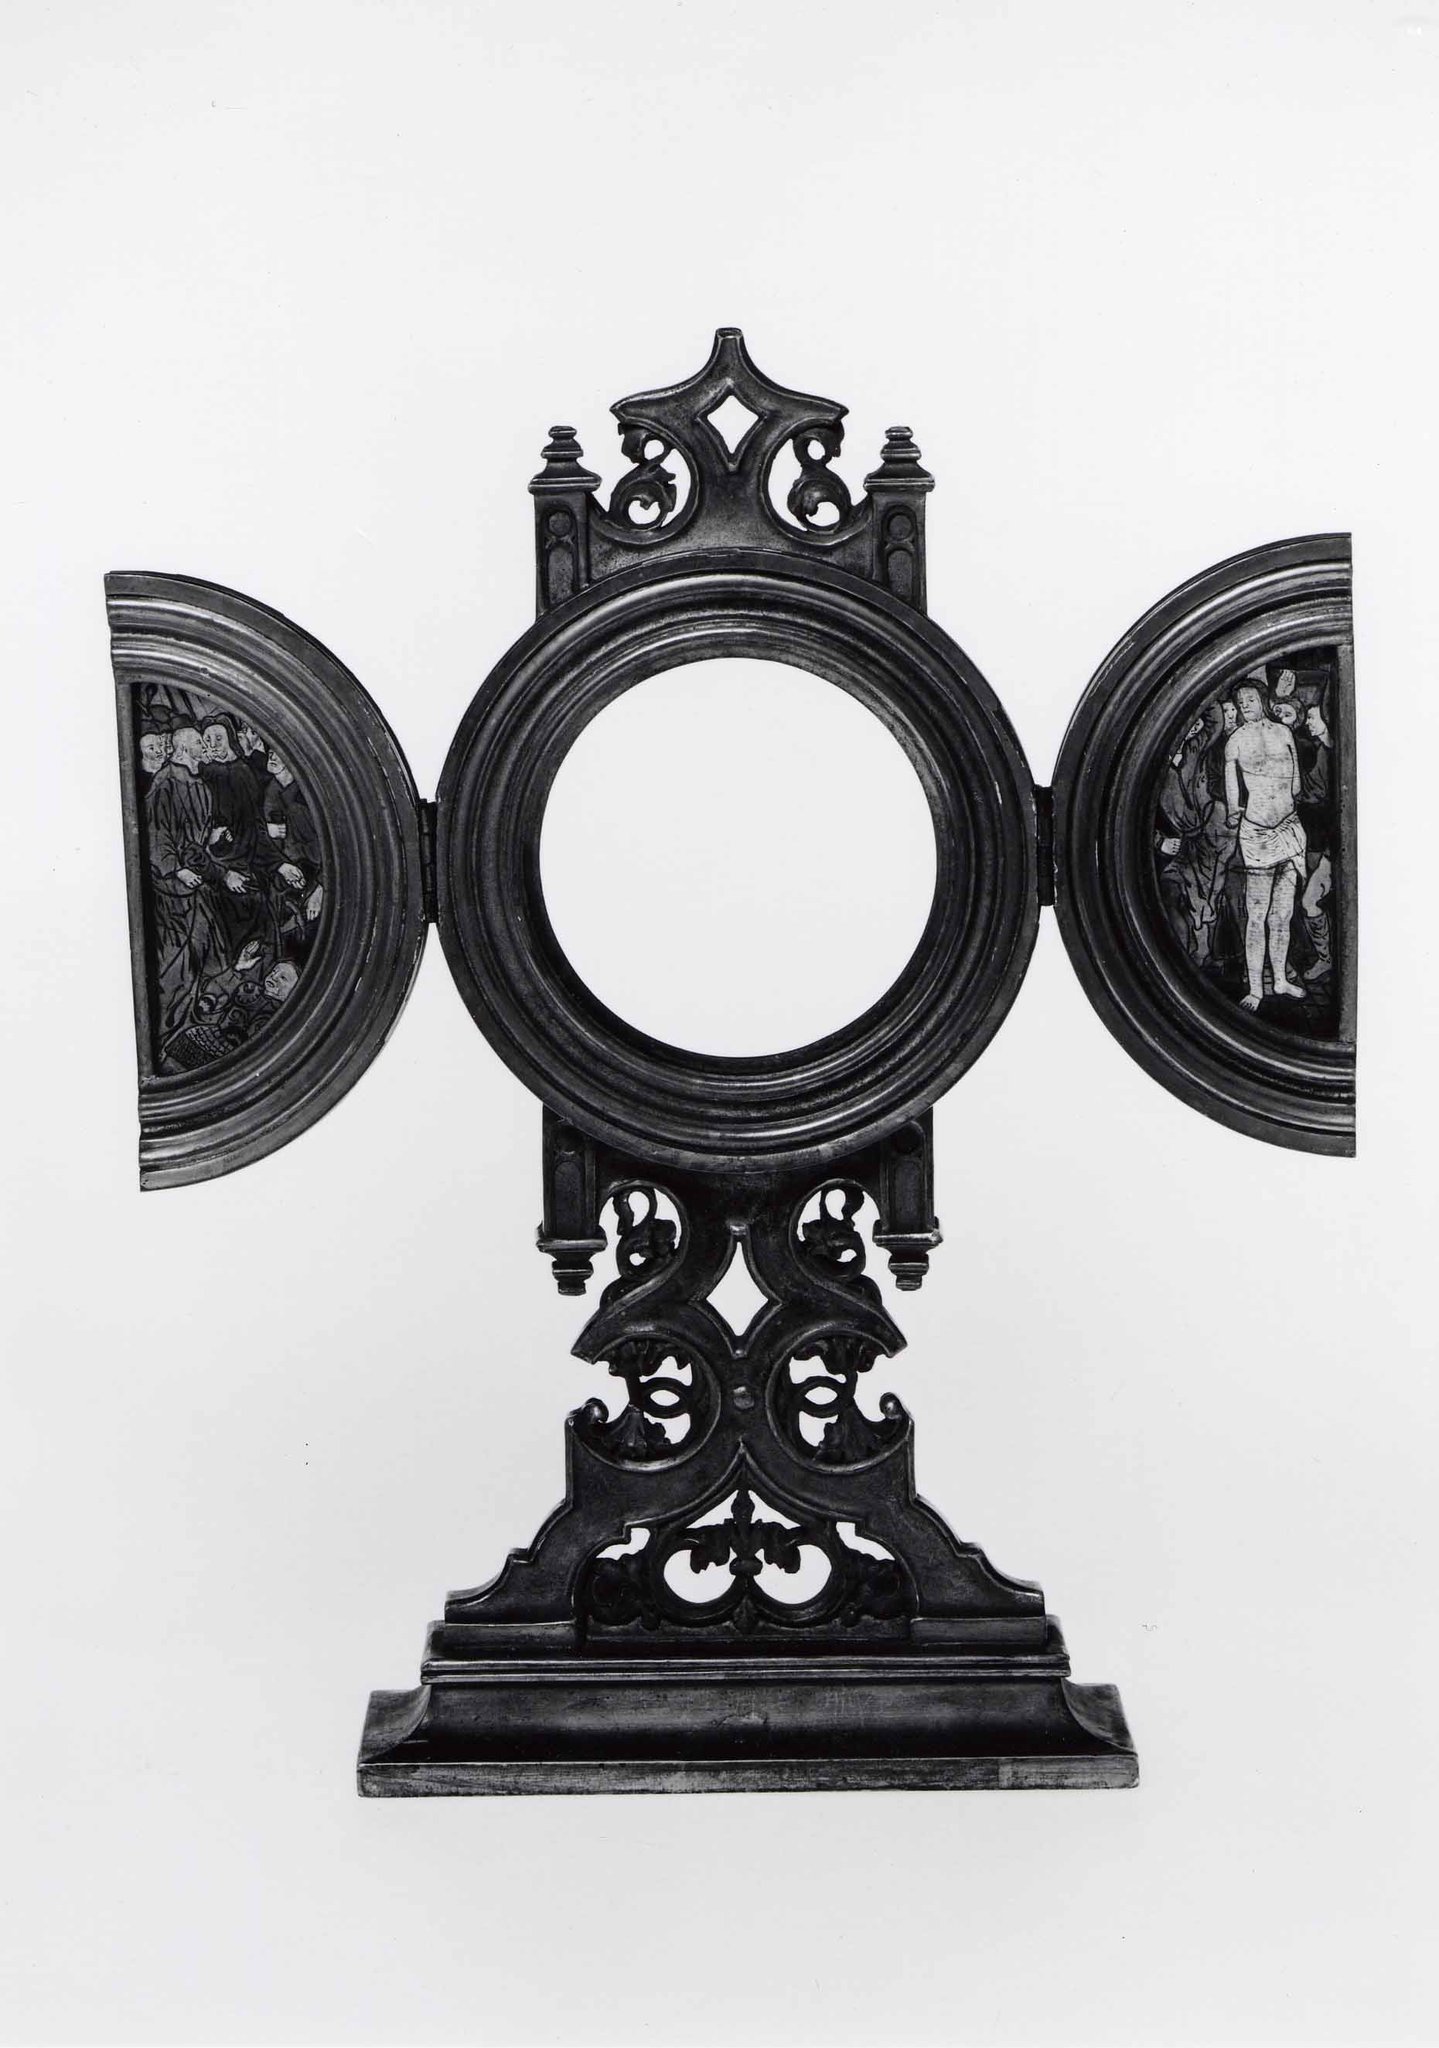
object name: monstrance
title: The Betrayal and Mocking of Christ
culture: european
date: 1900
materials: copper, gilt, glass, metal, wood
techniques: carving, enamel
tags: christ